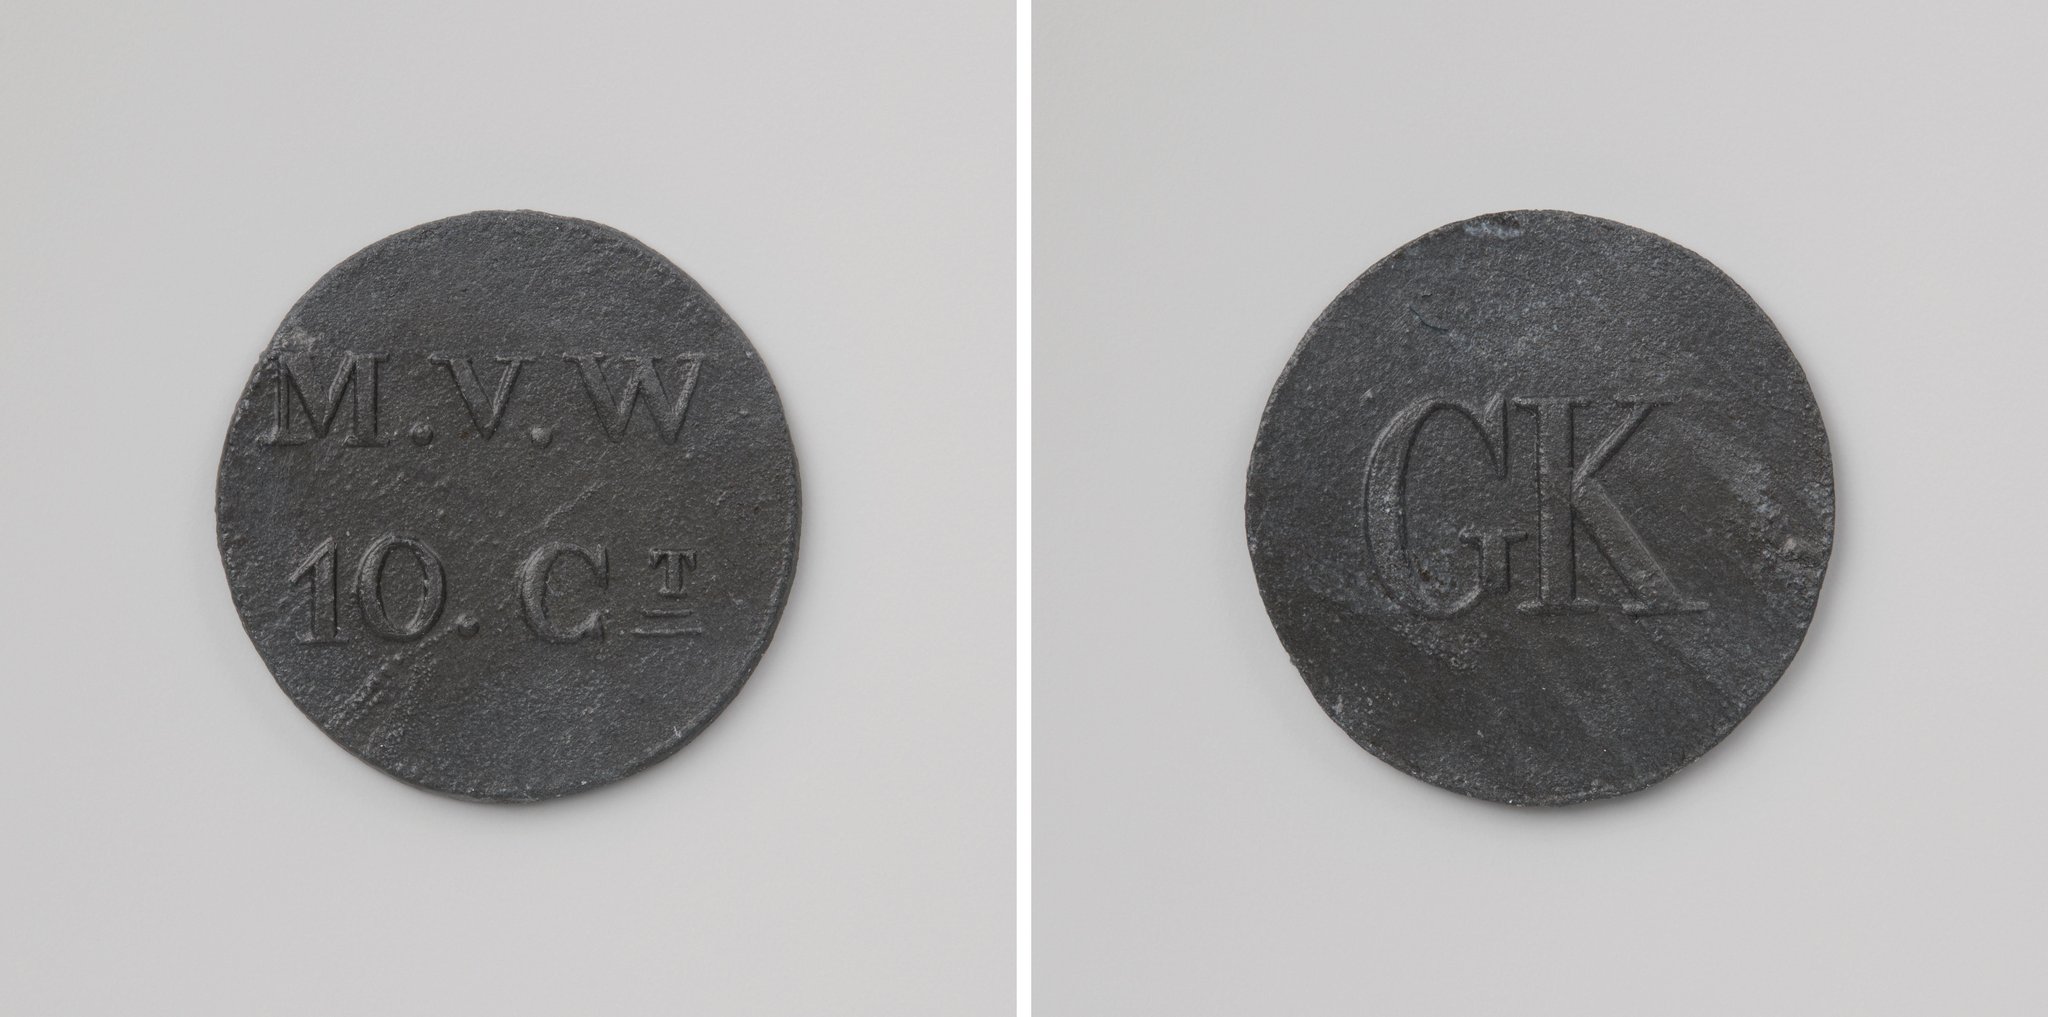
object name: monetary token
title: Huismunt geslagen op last van de Maatschappij van Weldadigheid ter waarde van tien cent, ten behoeve van de Gewone Koloniën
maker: Anonymous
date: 1818-1859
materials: zinc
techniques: striking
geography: netherlands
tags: maatschappij van weldadigheid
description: Zinken munt. Voorzijde: opschrift boven waardeaanduiding. Keerzijde: opschrift G en K